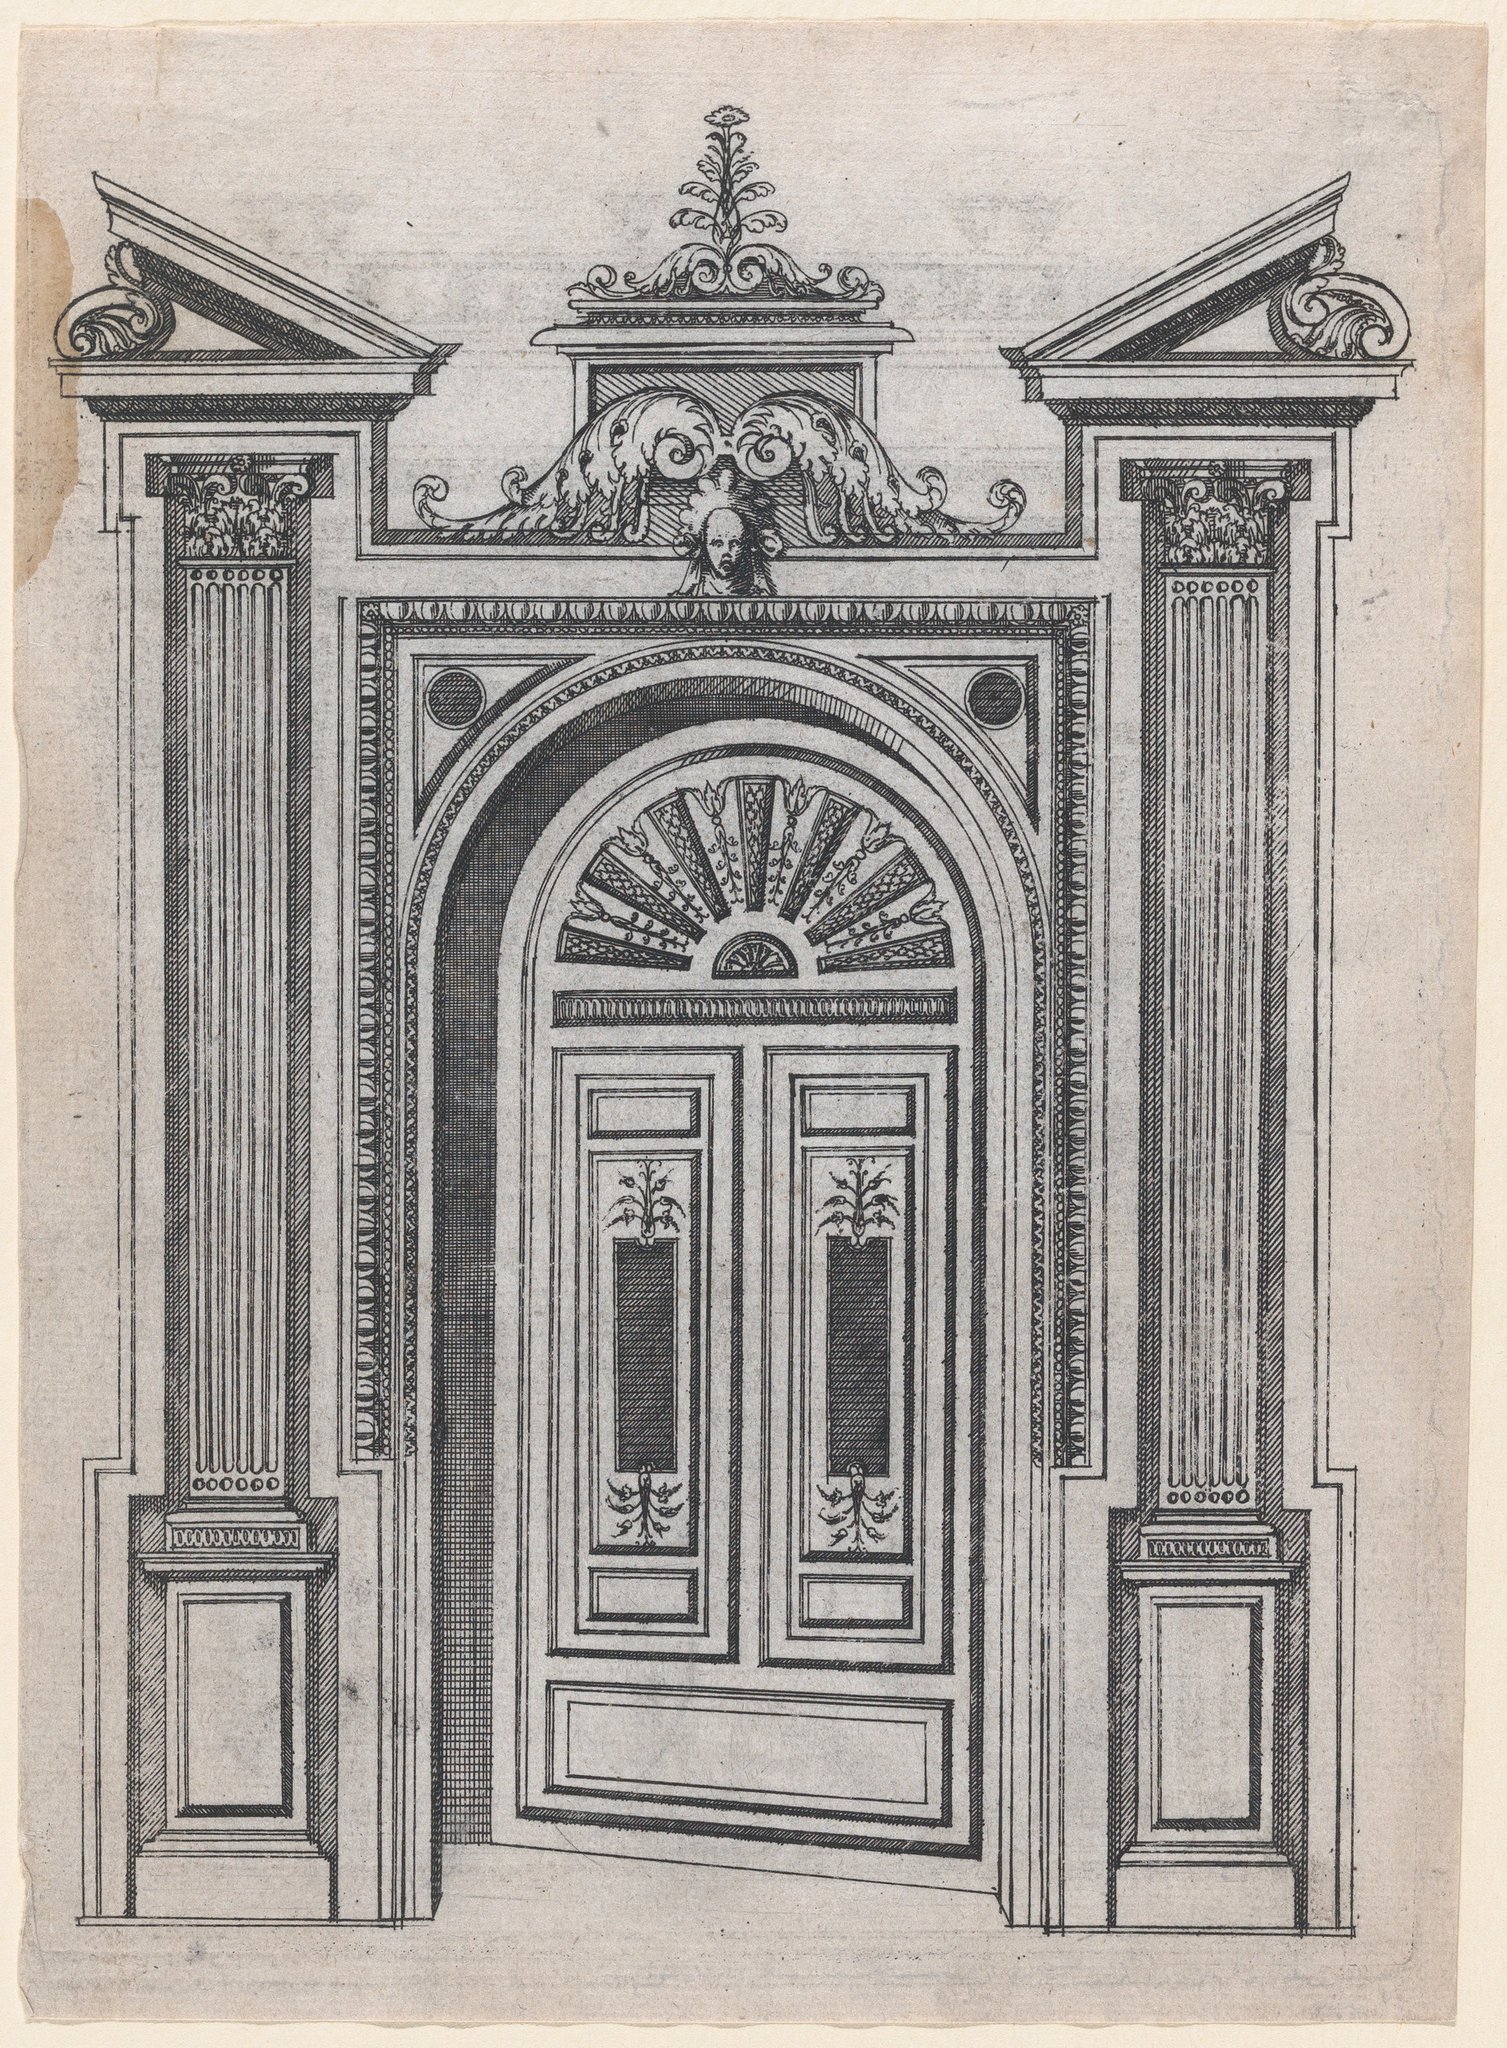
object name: print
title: Design for a Door Frame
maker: jacques androuet du cerceau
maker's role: artist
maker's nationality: french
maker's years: 1510-1585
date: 1565-1570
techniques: etching